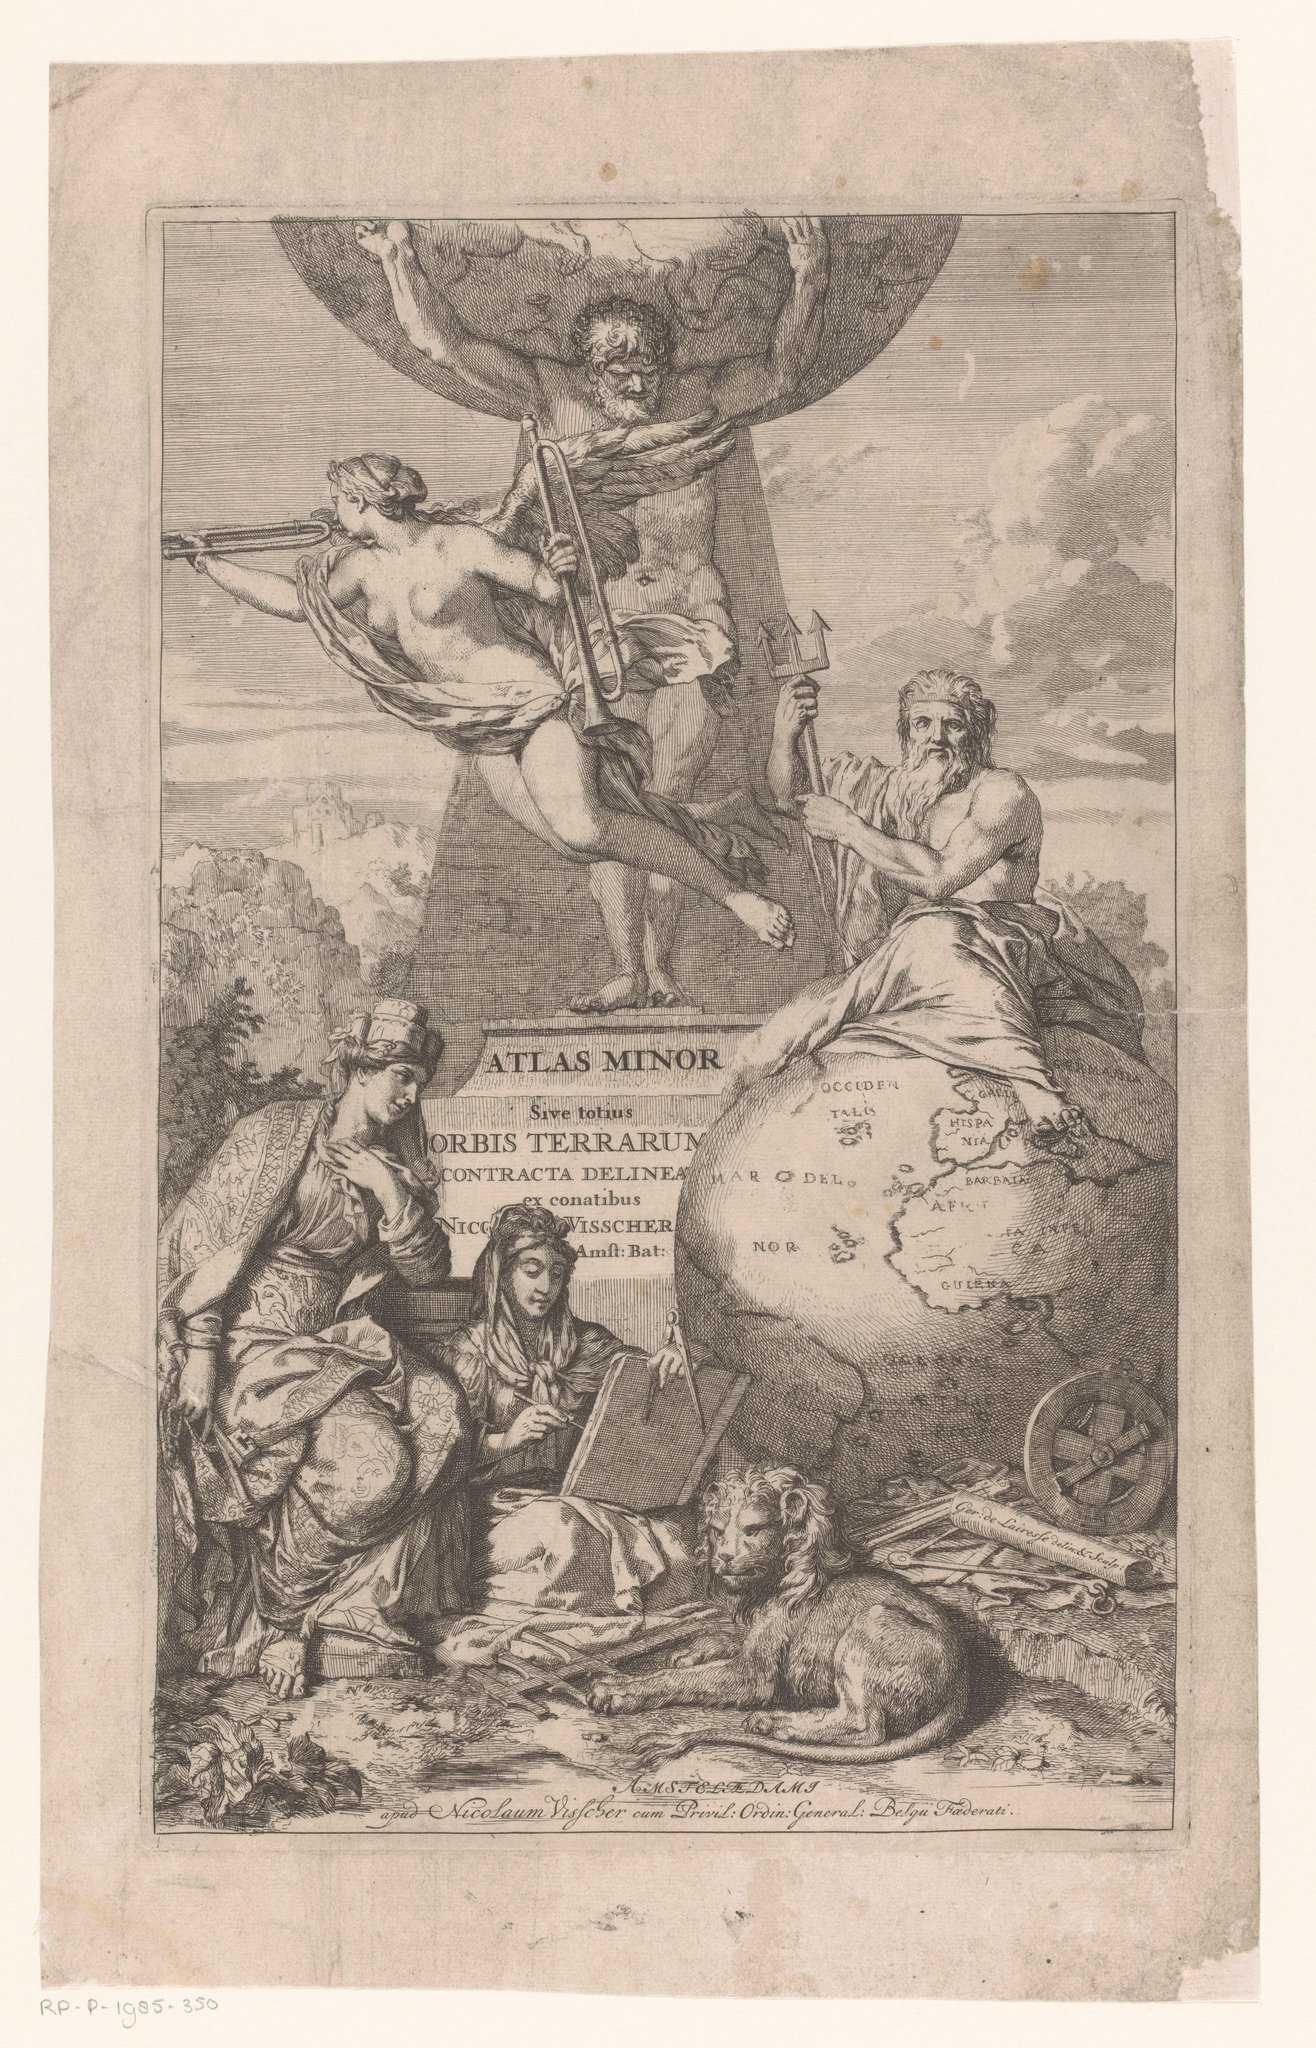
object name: print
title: Titelpagina voor: Nicolaes Visscher, Atlas minor sive totius orbis terrarum contracta delineata, 168X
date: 1689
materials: paper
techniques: etching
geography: amsterdam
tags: (story of) atlas - attributes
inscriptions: inscription: ‘28-11-85 / 1 + 2 + 3 + 6 / 12’, collector's mark: Lugt 2228, collector's mark: Lugt 2760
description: Atlas draagt de hemelglobe op zijn schouders en staat op een voetstuk. Links van hem blaast Faam de bazuin, rechts zit Neptunus op een wereldbol. Op de voorgrond zit uiterst links Cybele, de personificatie van aarde, met een kroon in de vorm van muren en torens op haar hoofd en een sleutel in haar hand. Naast haar beschrijft Geografia, personificatie van aardrijkskunde, een tekenbord. Geografia is omringd door diverse meetinstrumenten en houdt een passer vast. Aan haar voeten ligt een leeuw.